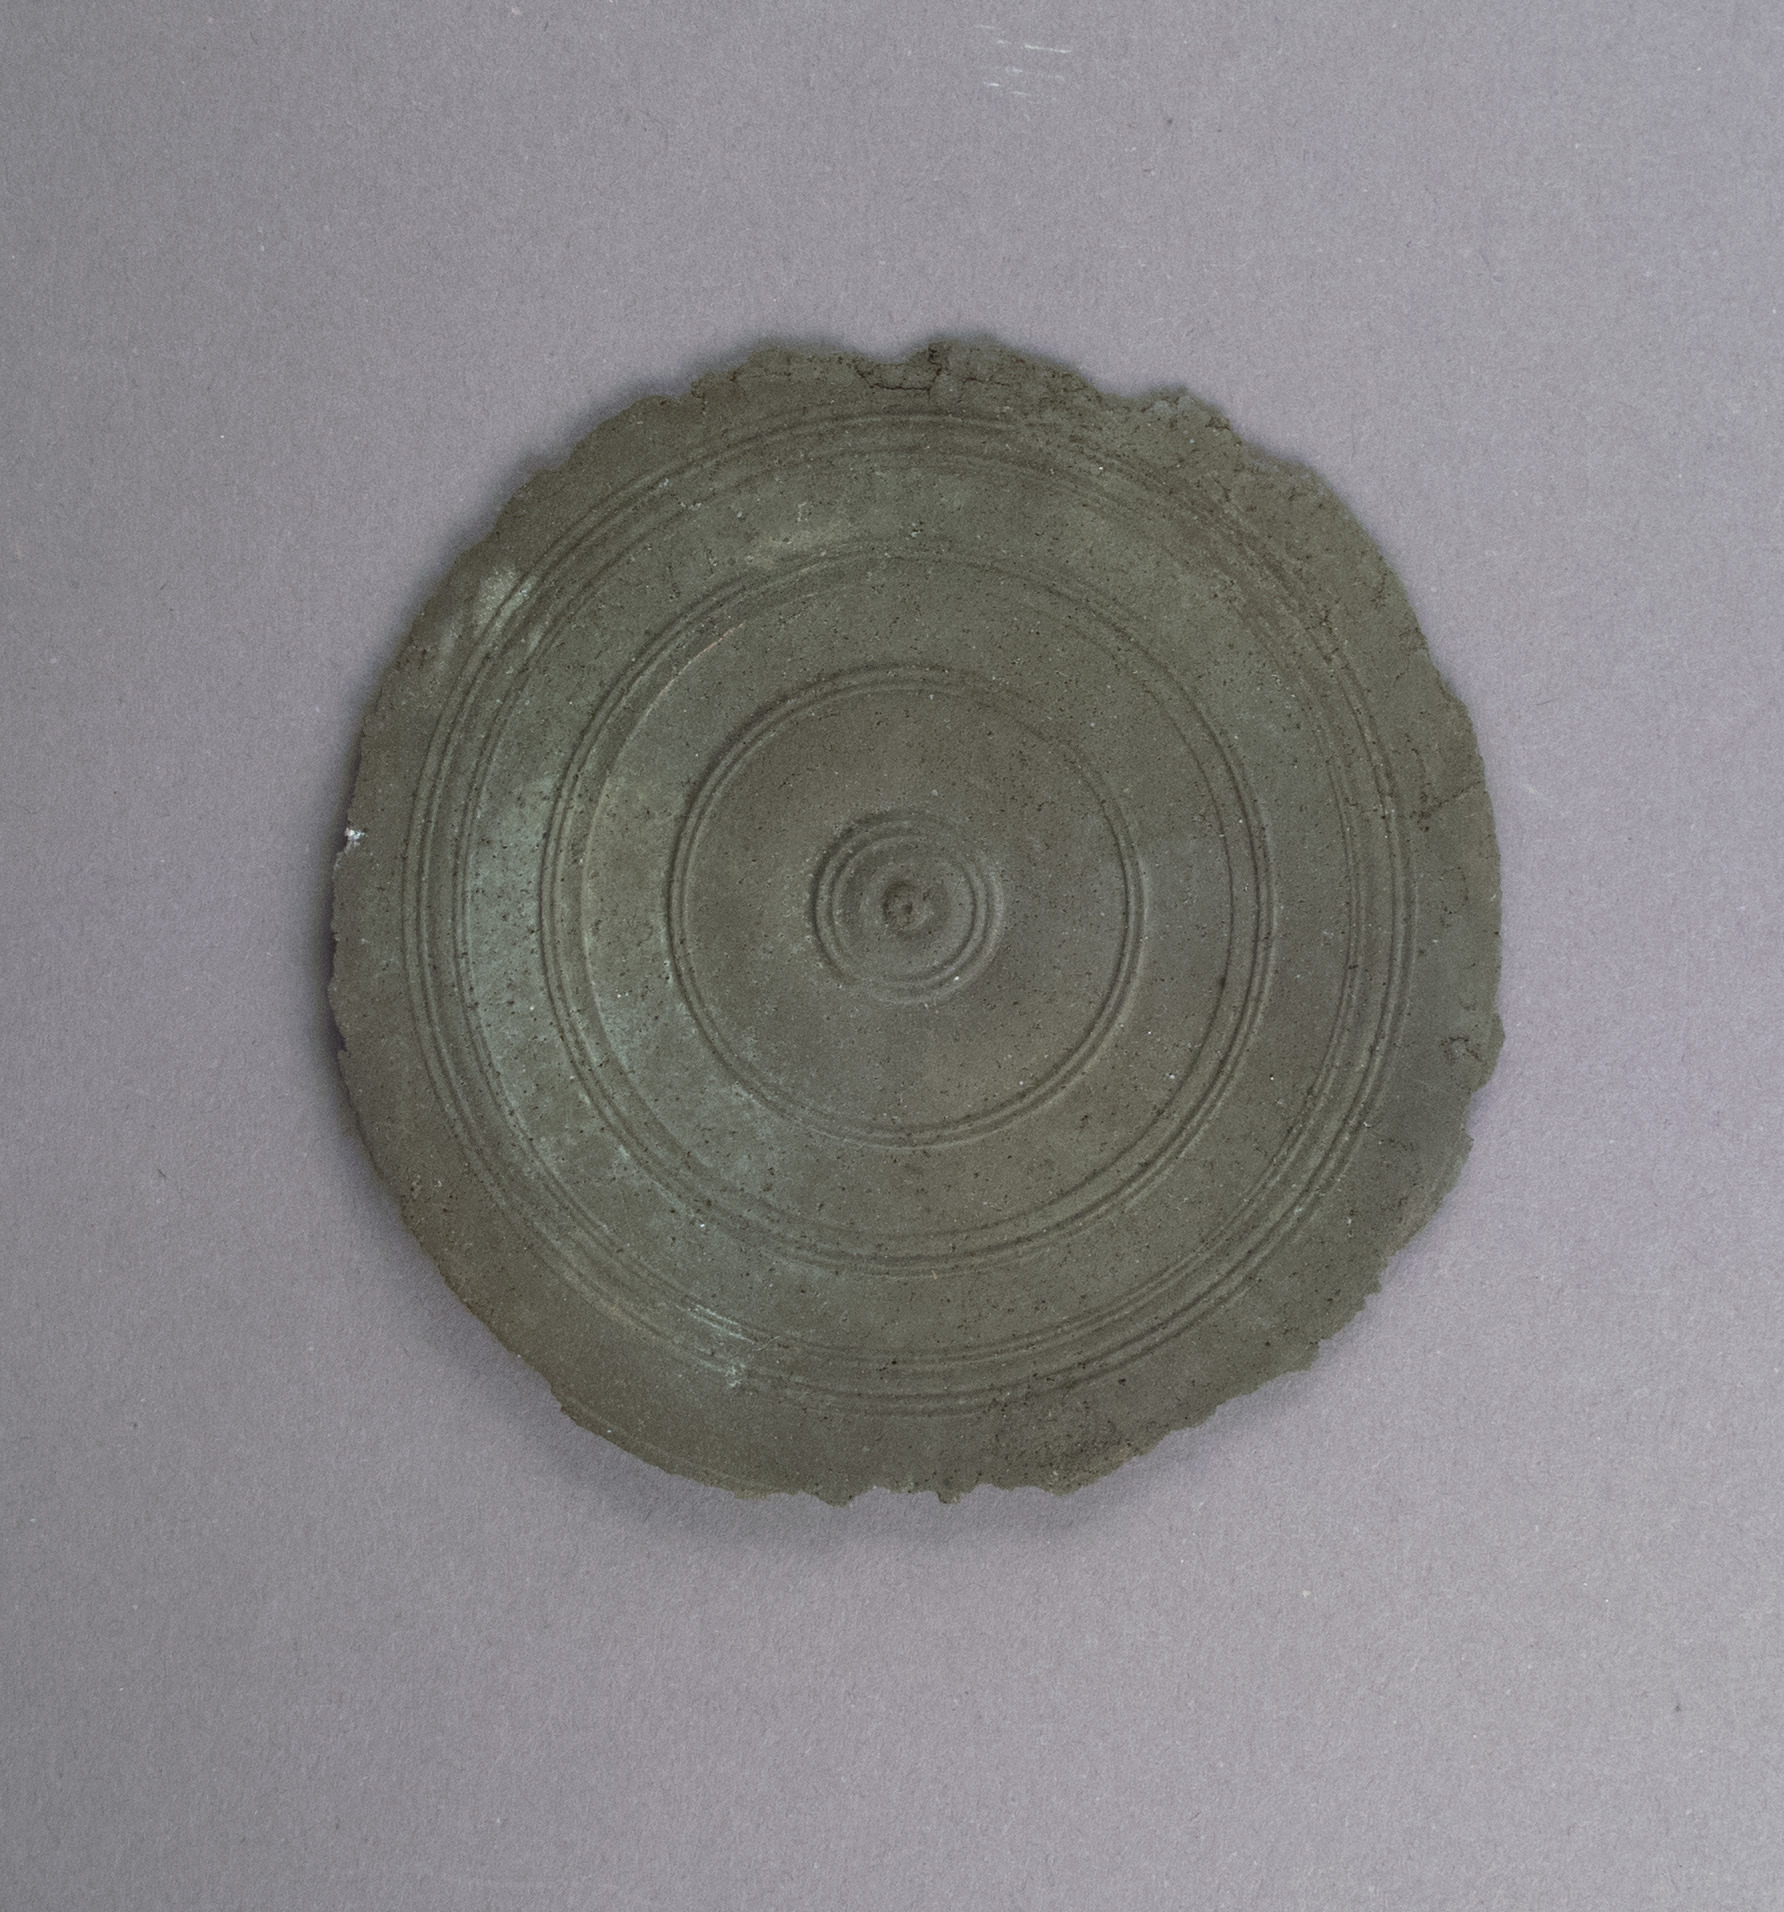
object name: amulet, figurine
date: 7000 BCE-330 CE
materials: silver